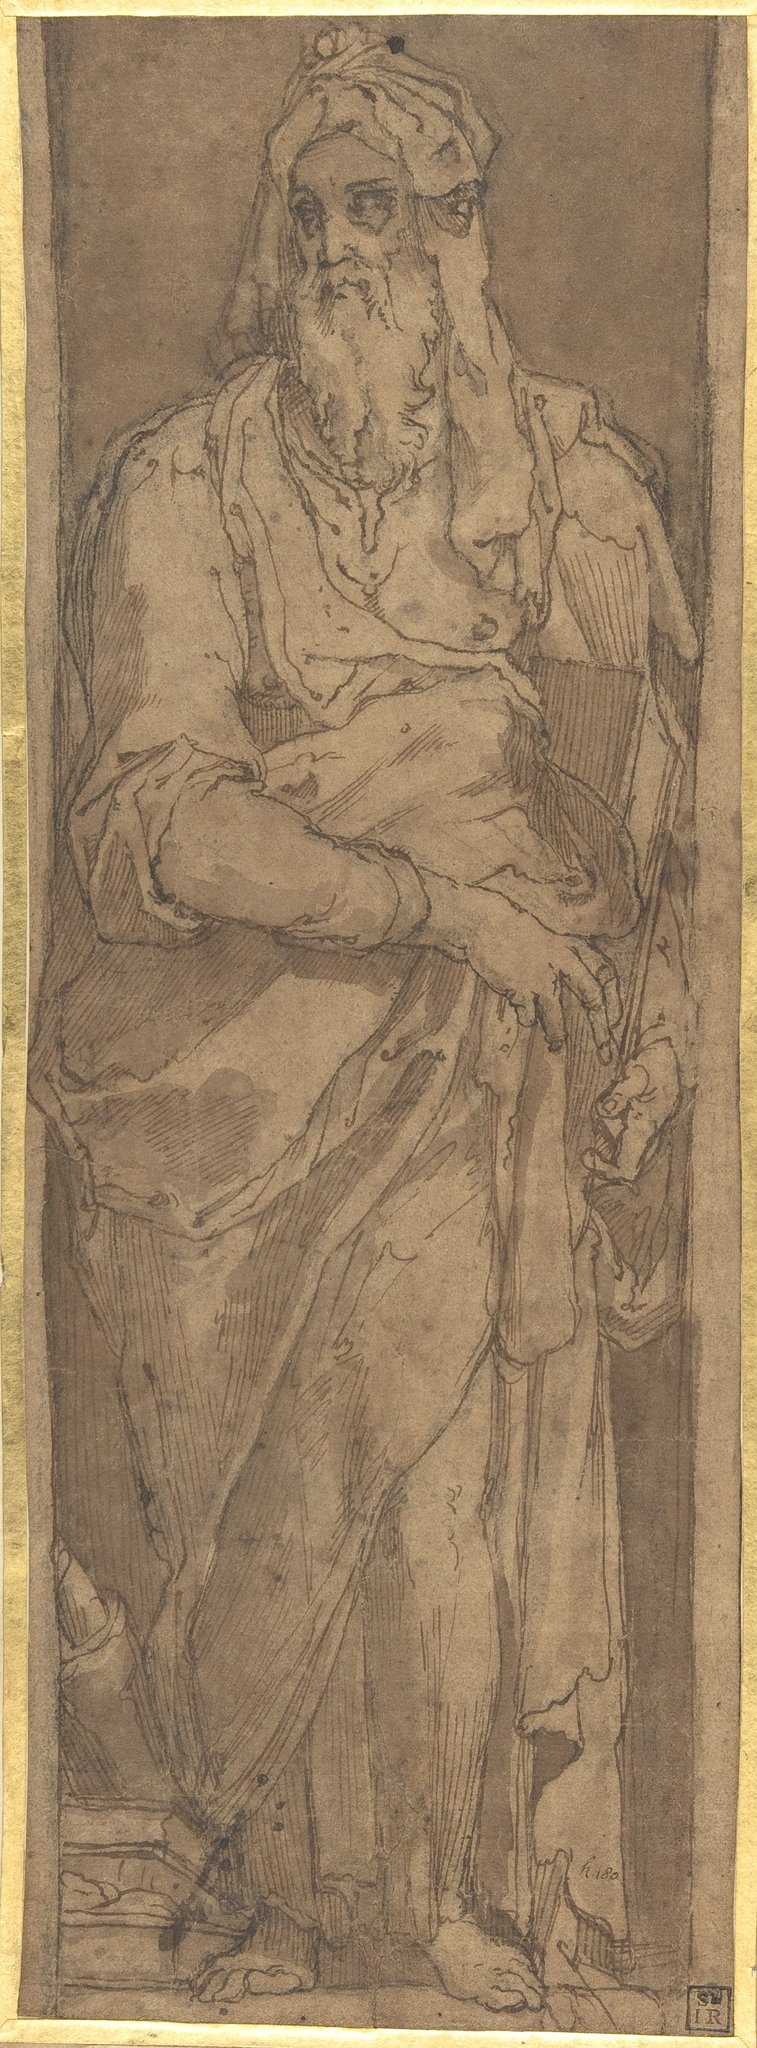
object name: drawing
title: Standing Prophet in a Niche, Holding a Book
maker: taddeo zuccaro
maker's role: artist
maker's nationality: italian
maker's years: 1529-1566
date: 1529-1566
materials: chalk, ink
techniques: brush, pen, wash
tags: books,men